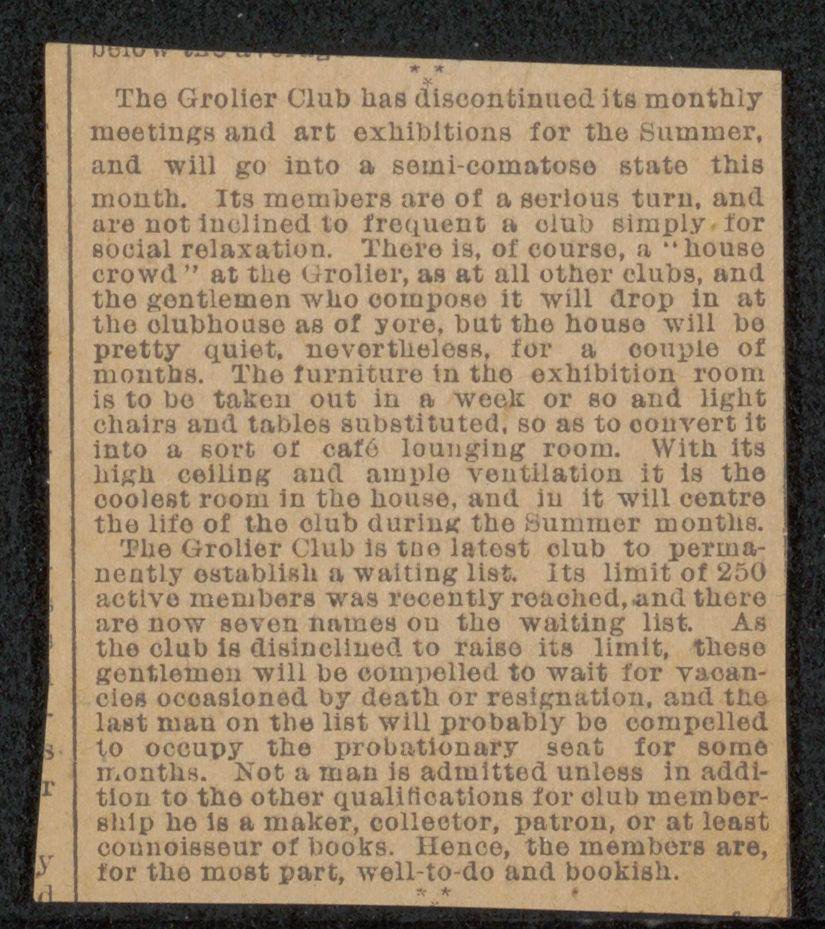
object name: newspaper clipping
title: Krantenknipsel uit archief Philip Zilcken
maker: Anonymous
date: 1832-1904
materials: paper, ink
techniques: printing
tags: new york (city), samuel putnam avery, the hague, painter, philip zilcken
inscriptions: collector's mark: ‘RPK’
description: Het knipsel is bewaard bij correspondentie van Samuel Putnam Avery aan Philip Zilcken.